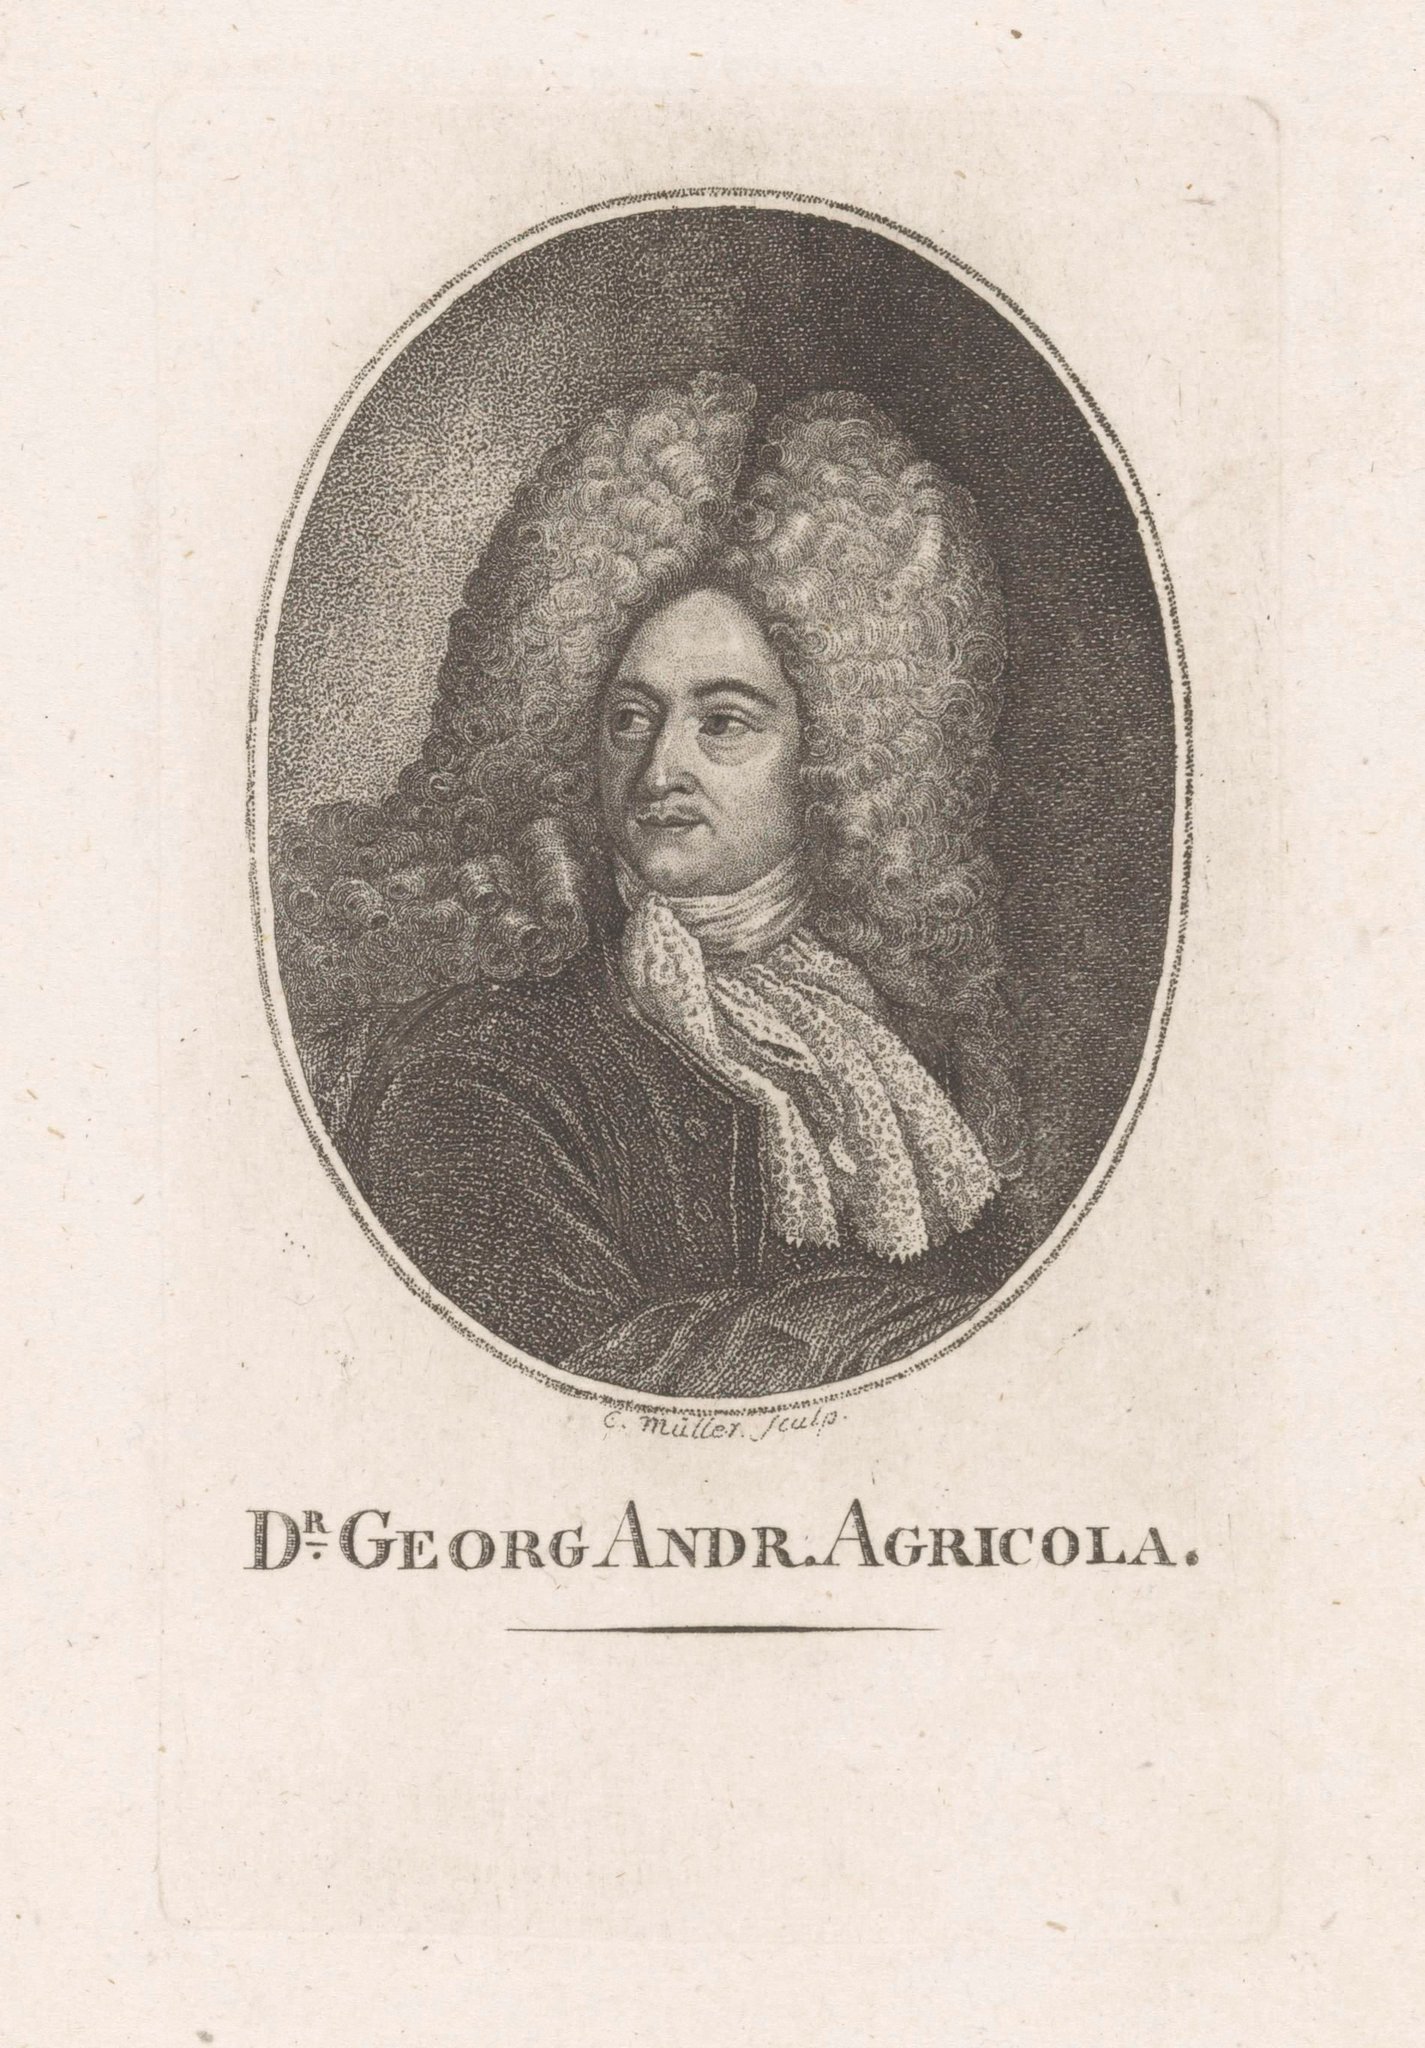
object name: print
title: Portret van Georg Andreas Agricola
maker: c. müller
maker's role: print maker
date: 1697-1749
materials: paper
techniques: stippled etching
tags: regensburg, arts, georg andreas agricola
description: Portret van Georg Andreas Agricola in een ovale omlijsting. In de ondermarge zijn naam en titel.